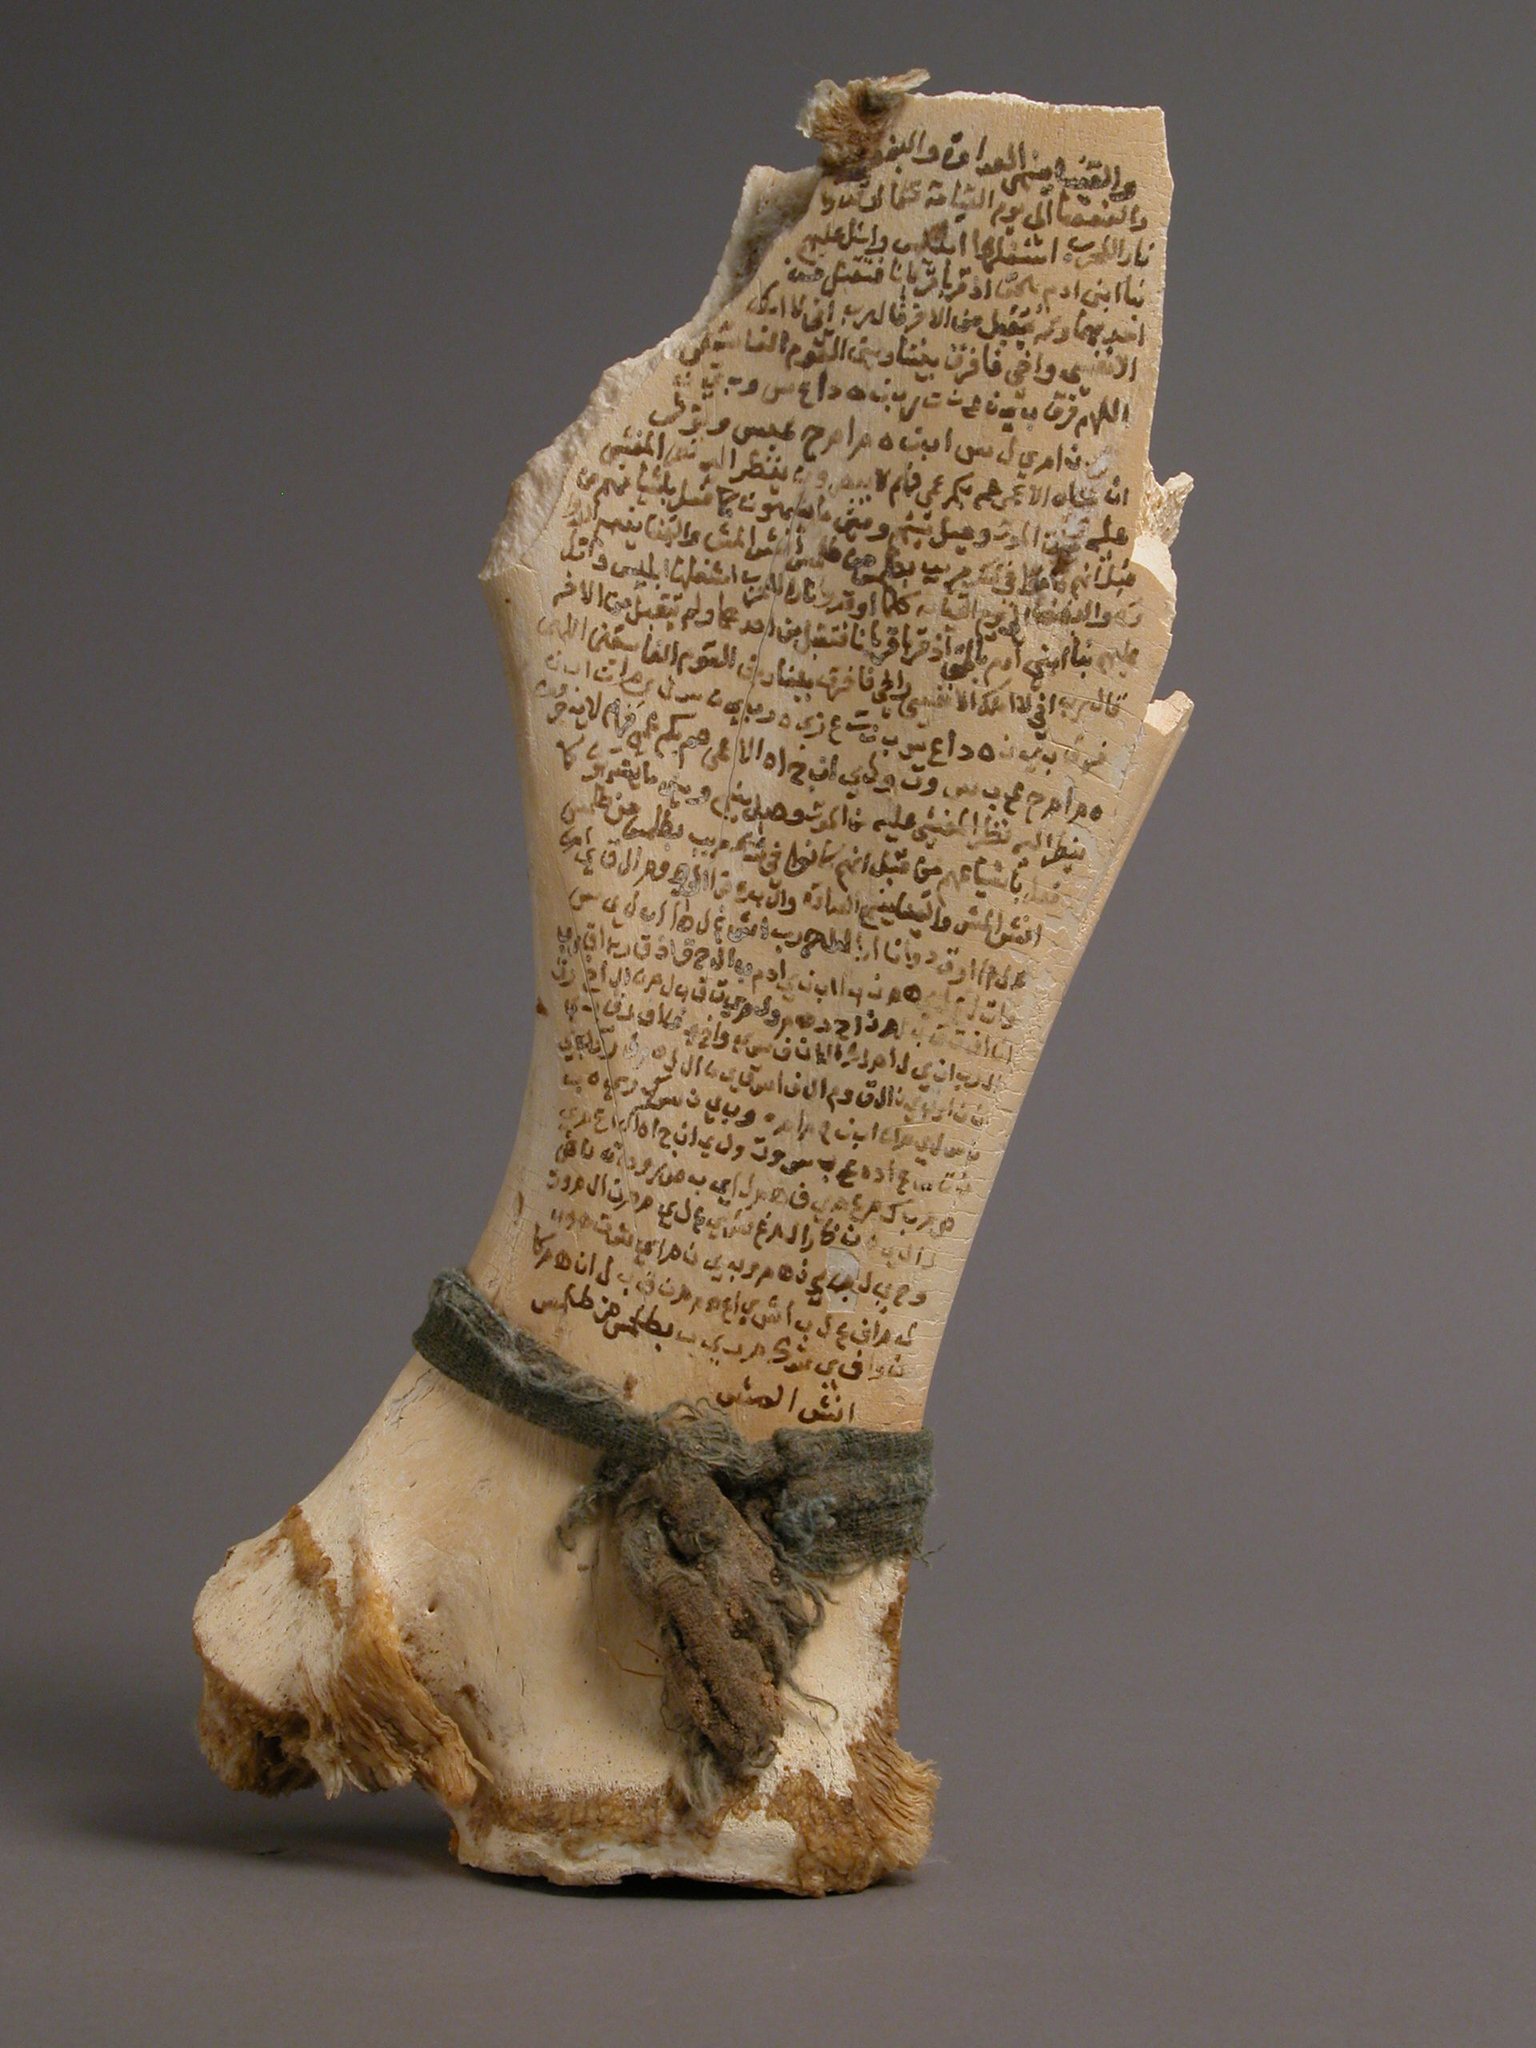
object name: bone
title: Bone with Inscription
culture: coptic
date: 301-700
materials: bone, ink, textile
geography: egypt